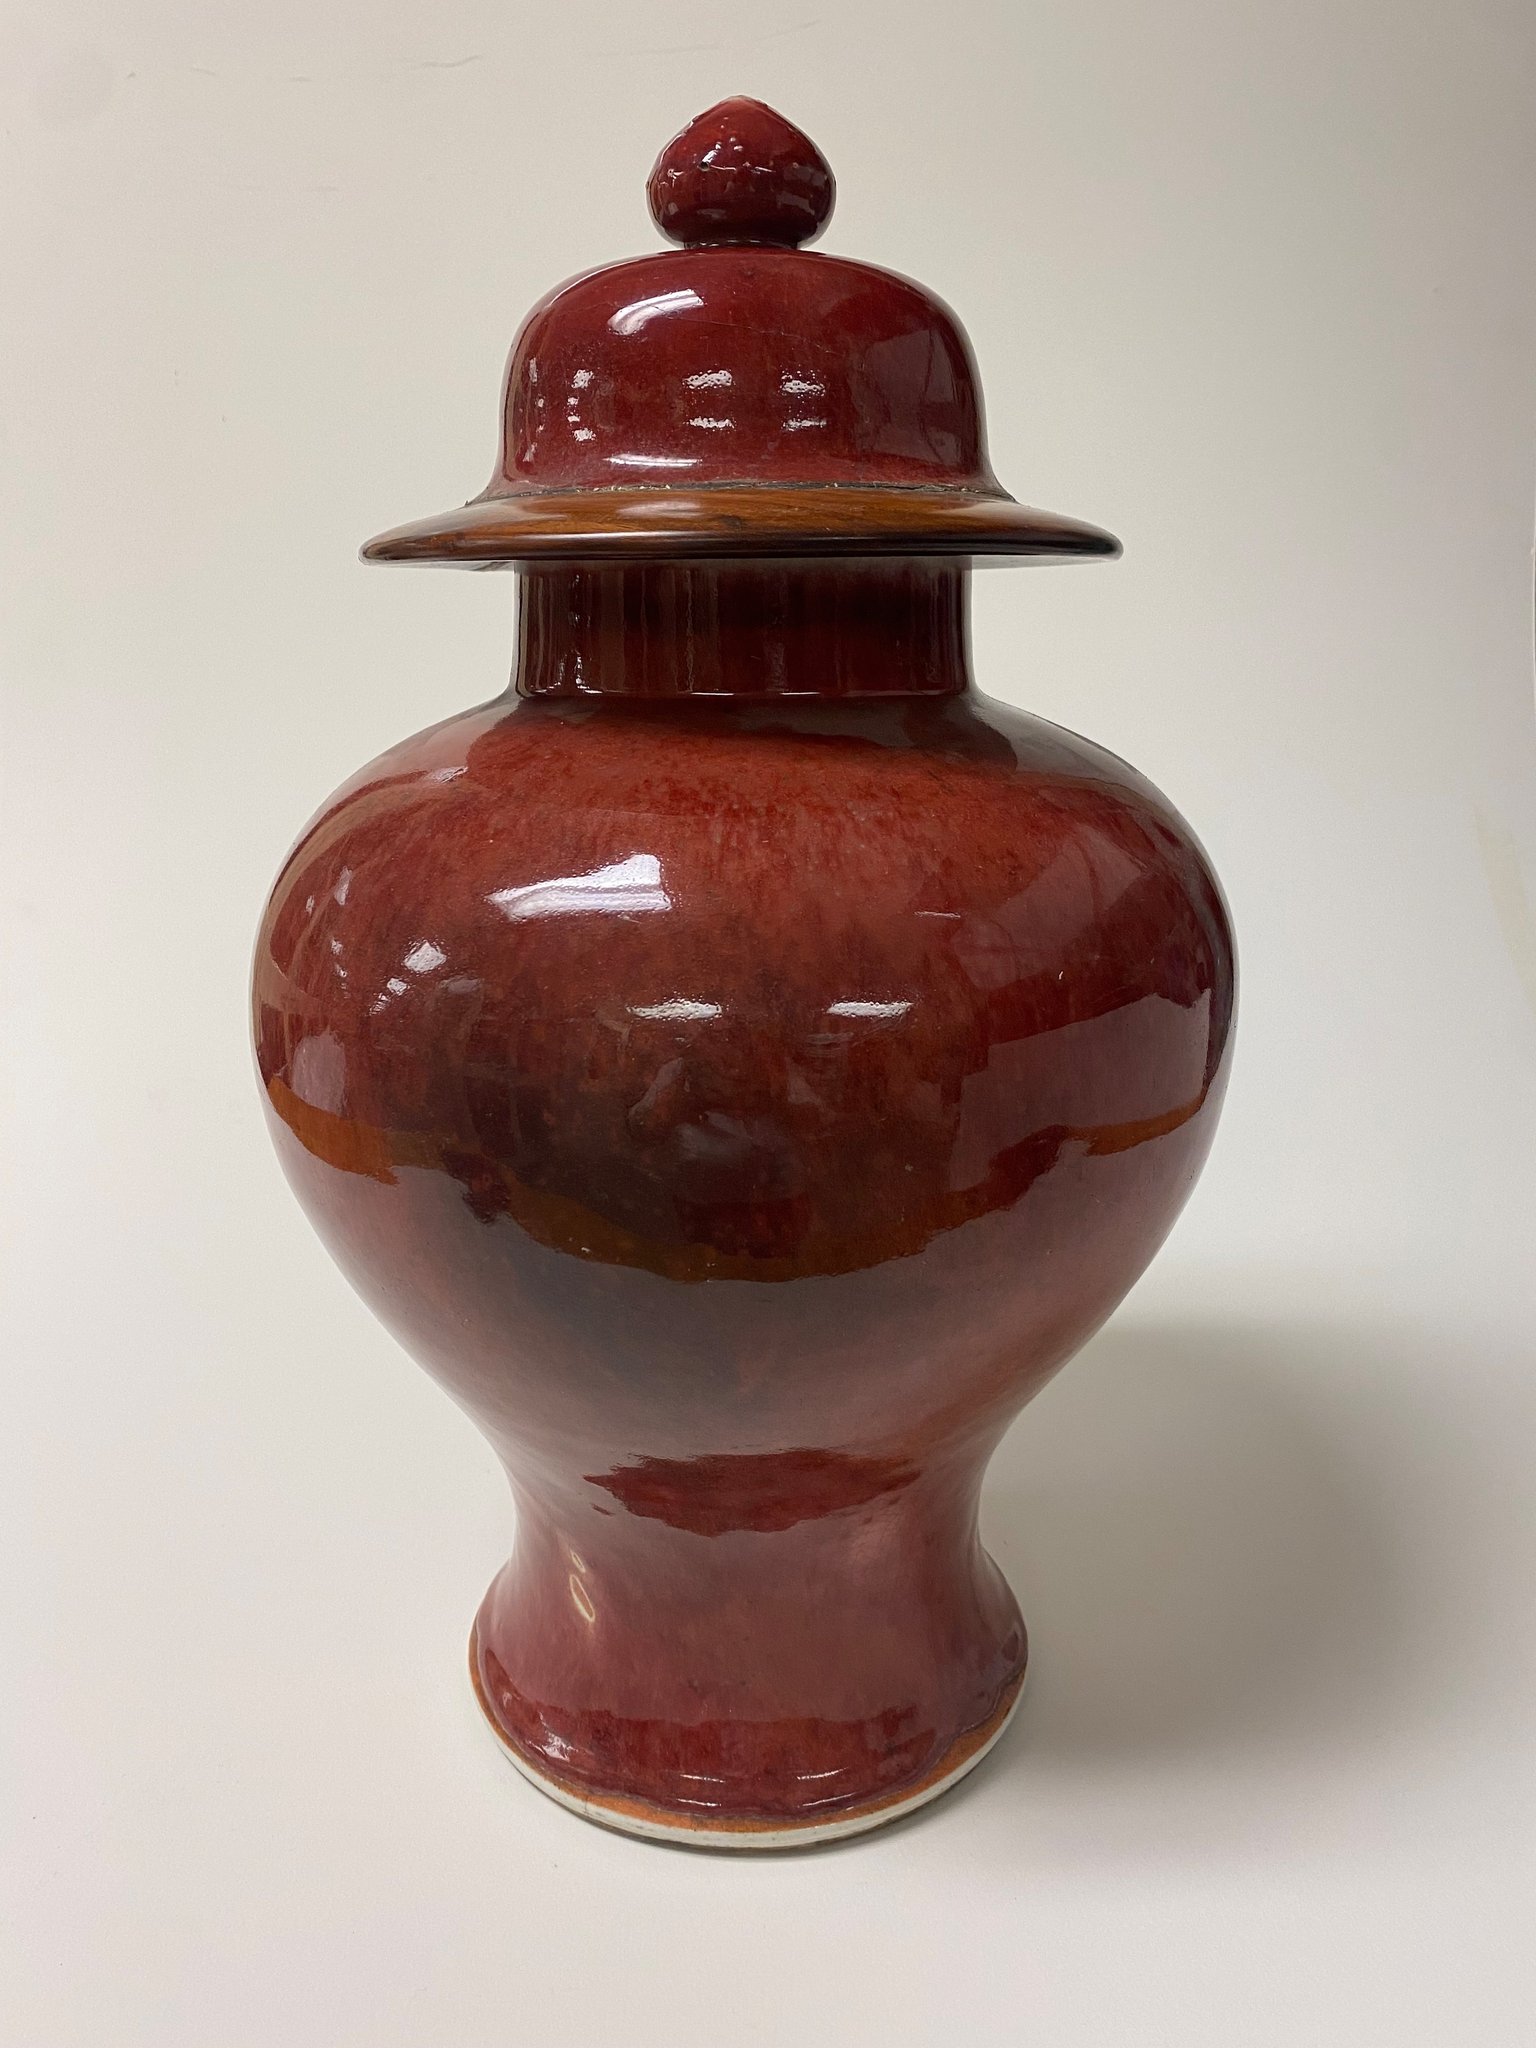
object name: covered jar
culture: chinese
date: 1667-1733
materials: copper, glaze, porcelain